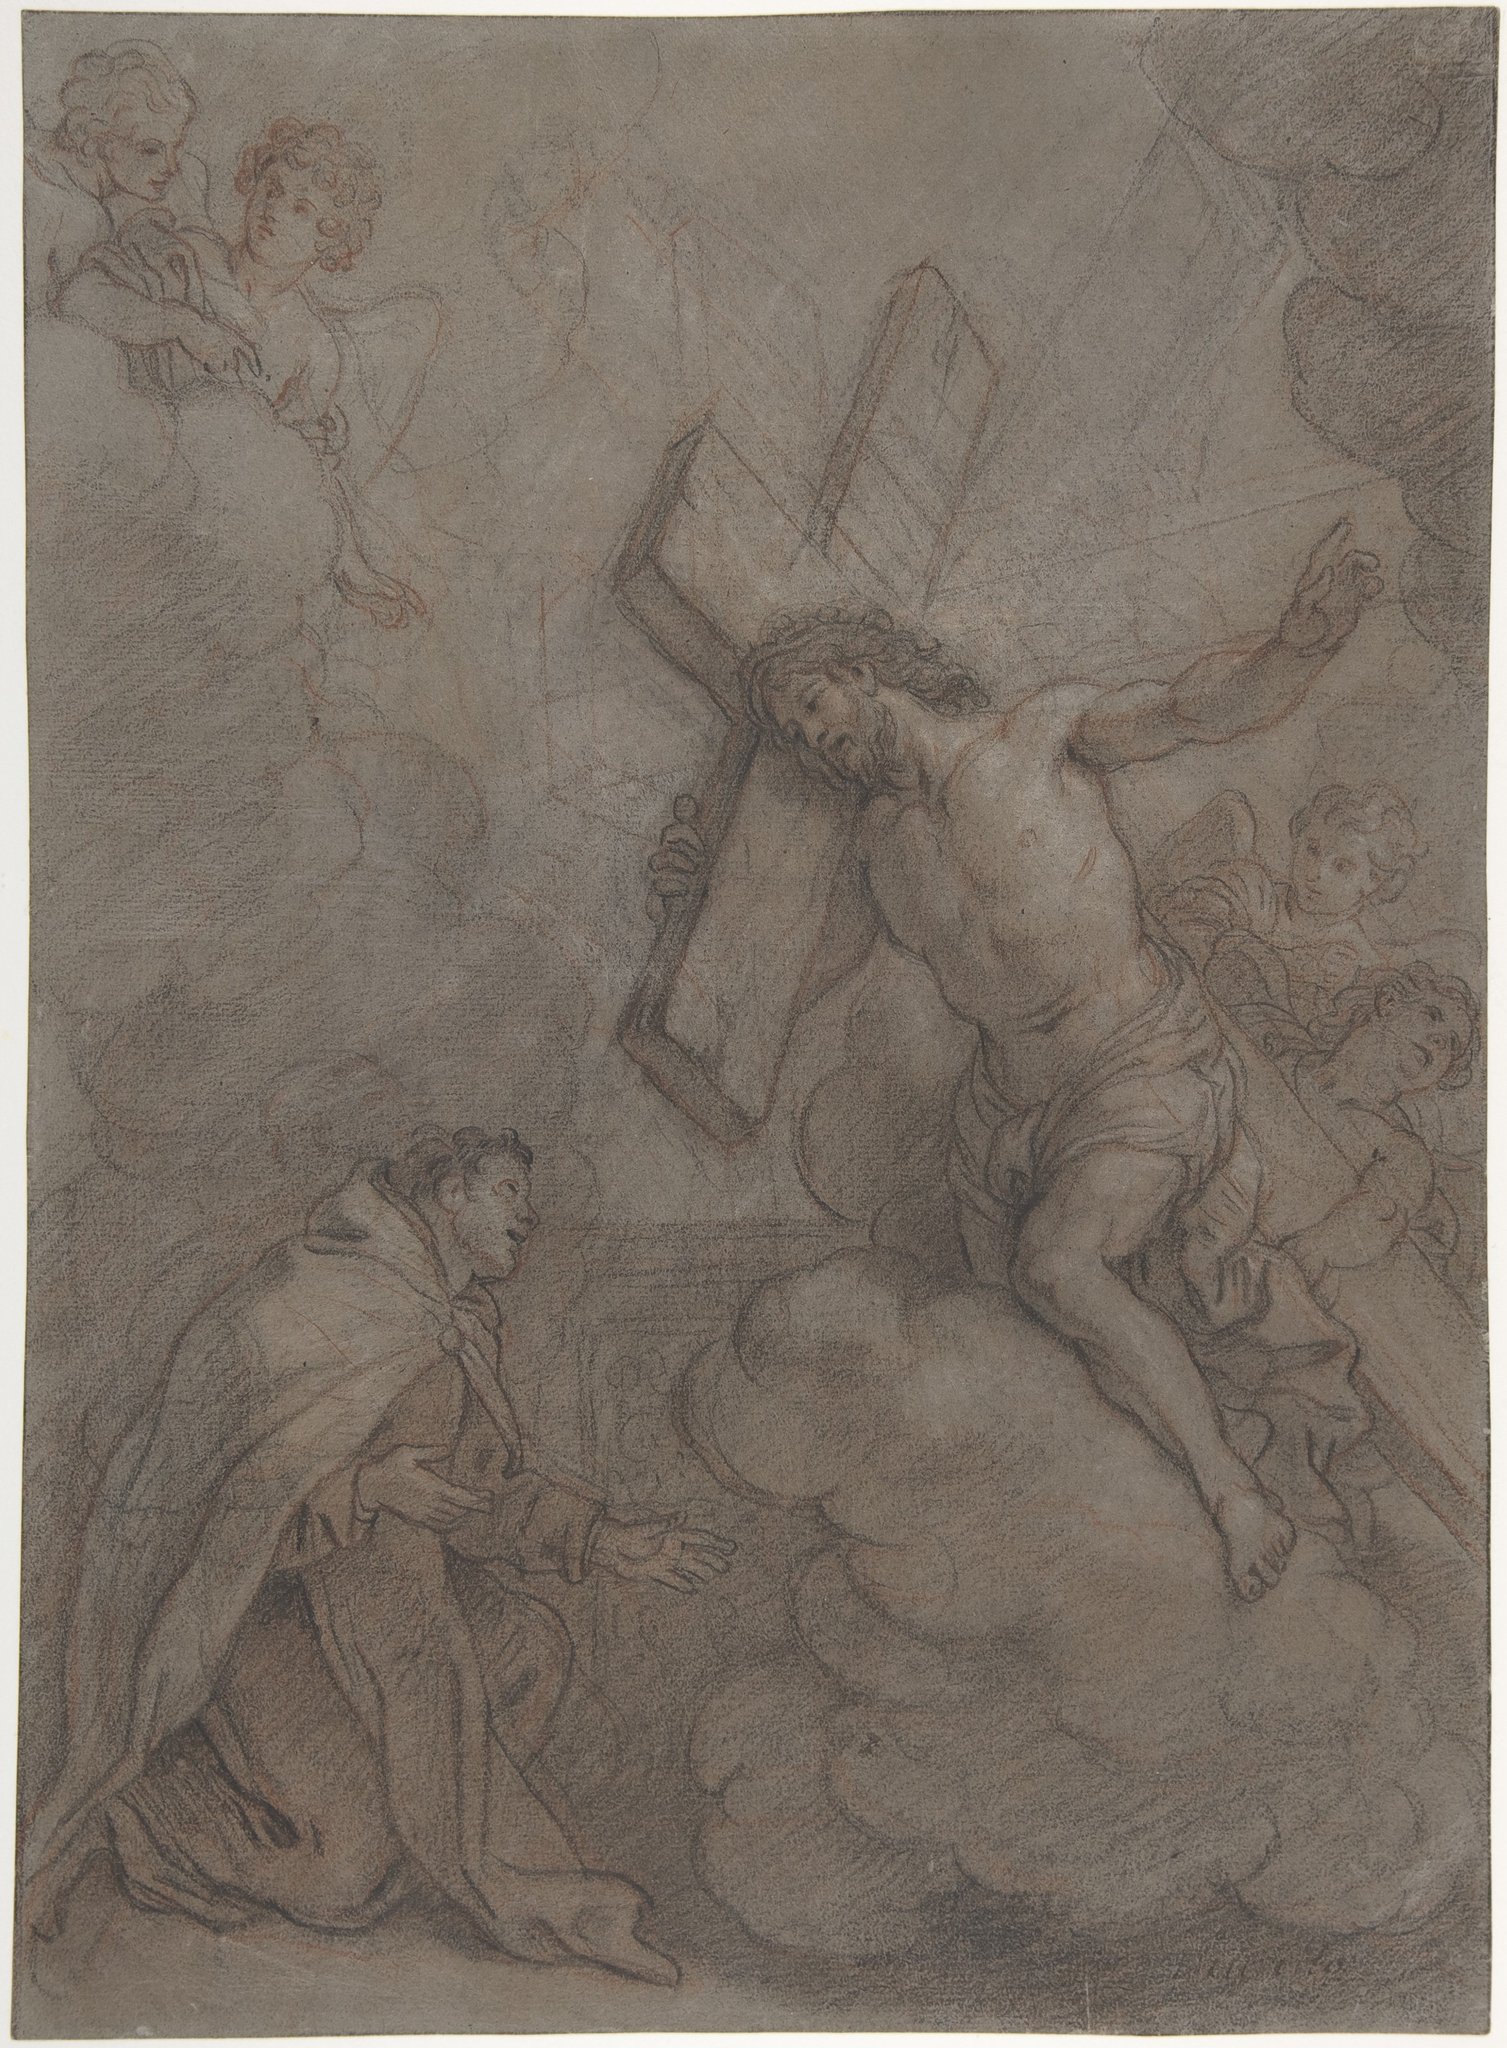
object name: drawing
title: The Vision of St. John of the Cross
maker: charles de la fosse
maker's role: artist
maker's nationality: french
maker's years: 1636-1716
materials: chalk, paper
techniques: heightening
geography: france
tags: angels,saint john the baptist,cross,jesus